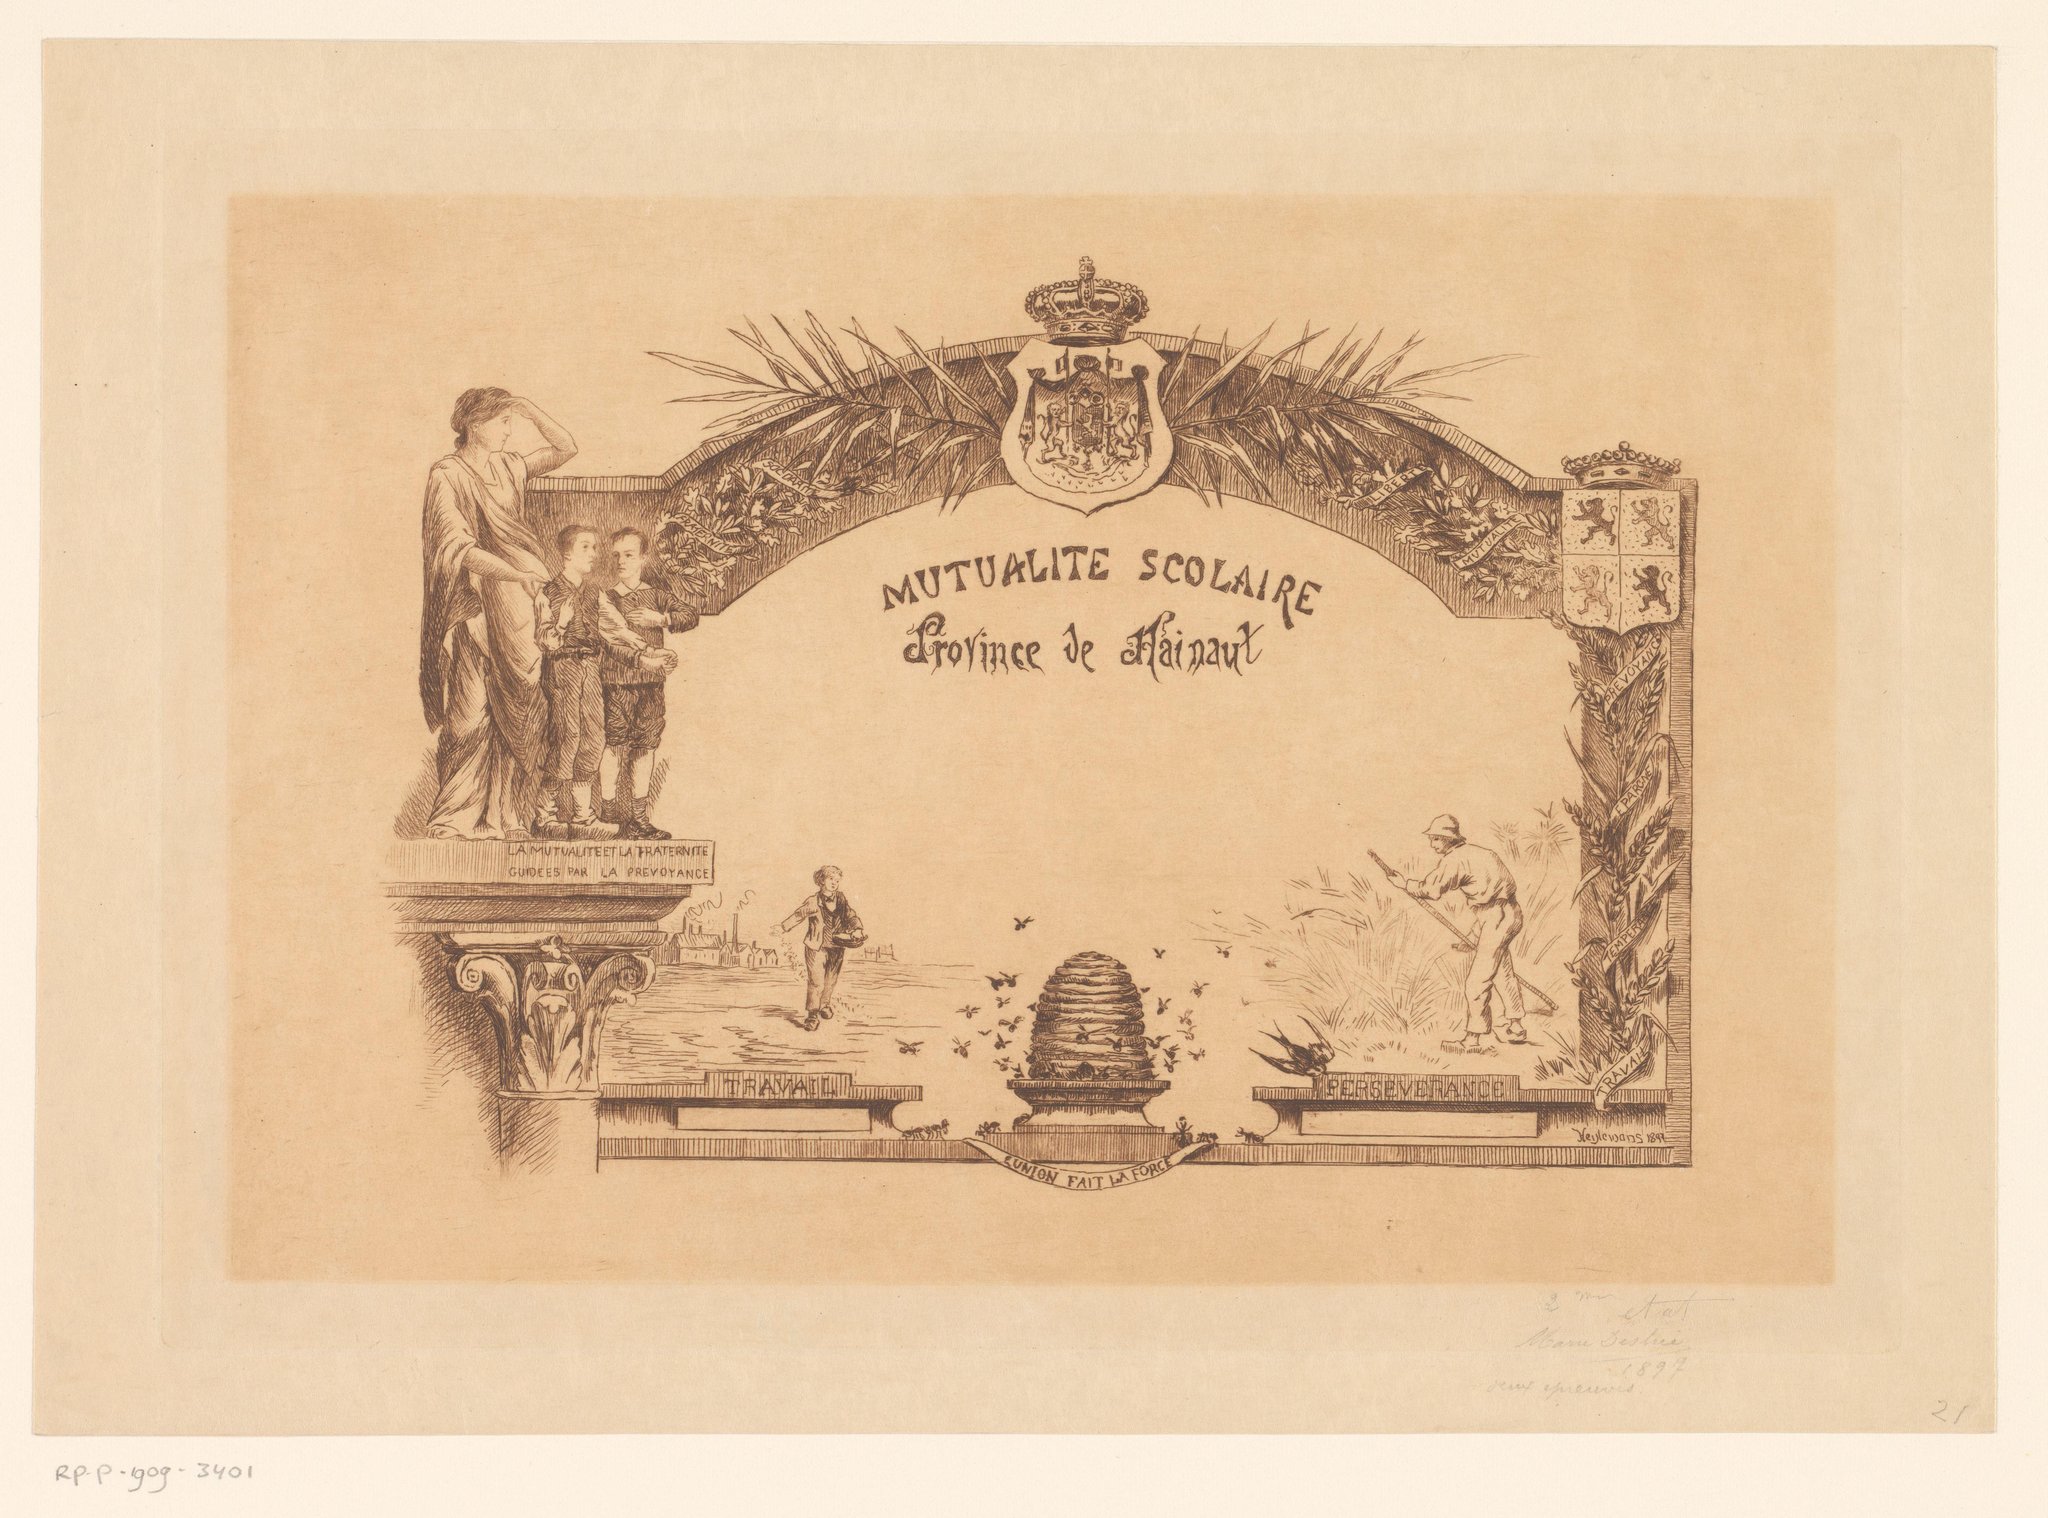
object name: certificate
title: Diploma voor de Mutualité scolaire, Henegouwen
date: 1897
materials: paper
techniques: etching, intaglio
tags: bee-hive, sowing, henegouwen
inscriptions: collector's mark: Lugt 2228, inscription: ‘2m etat; 1897; Deux epreuves’, mark: ‘Heijle[mans]’